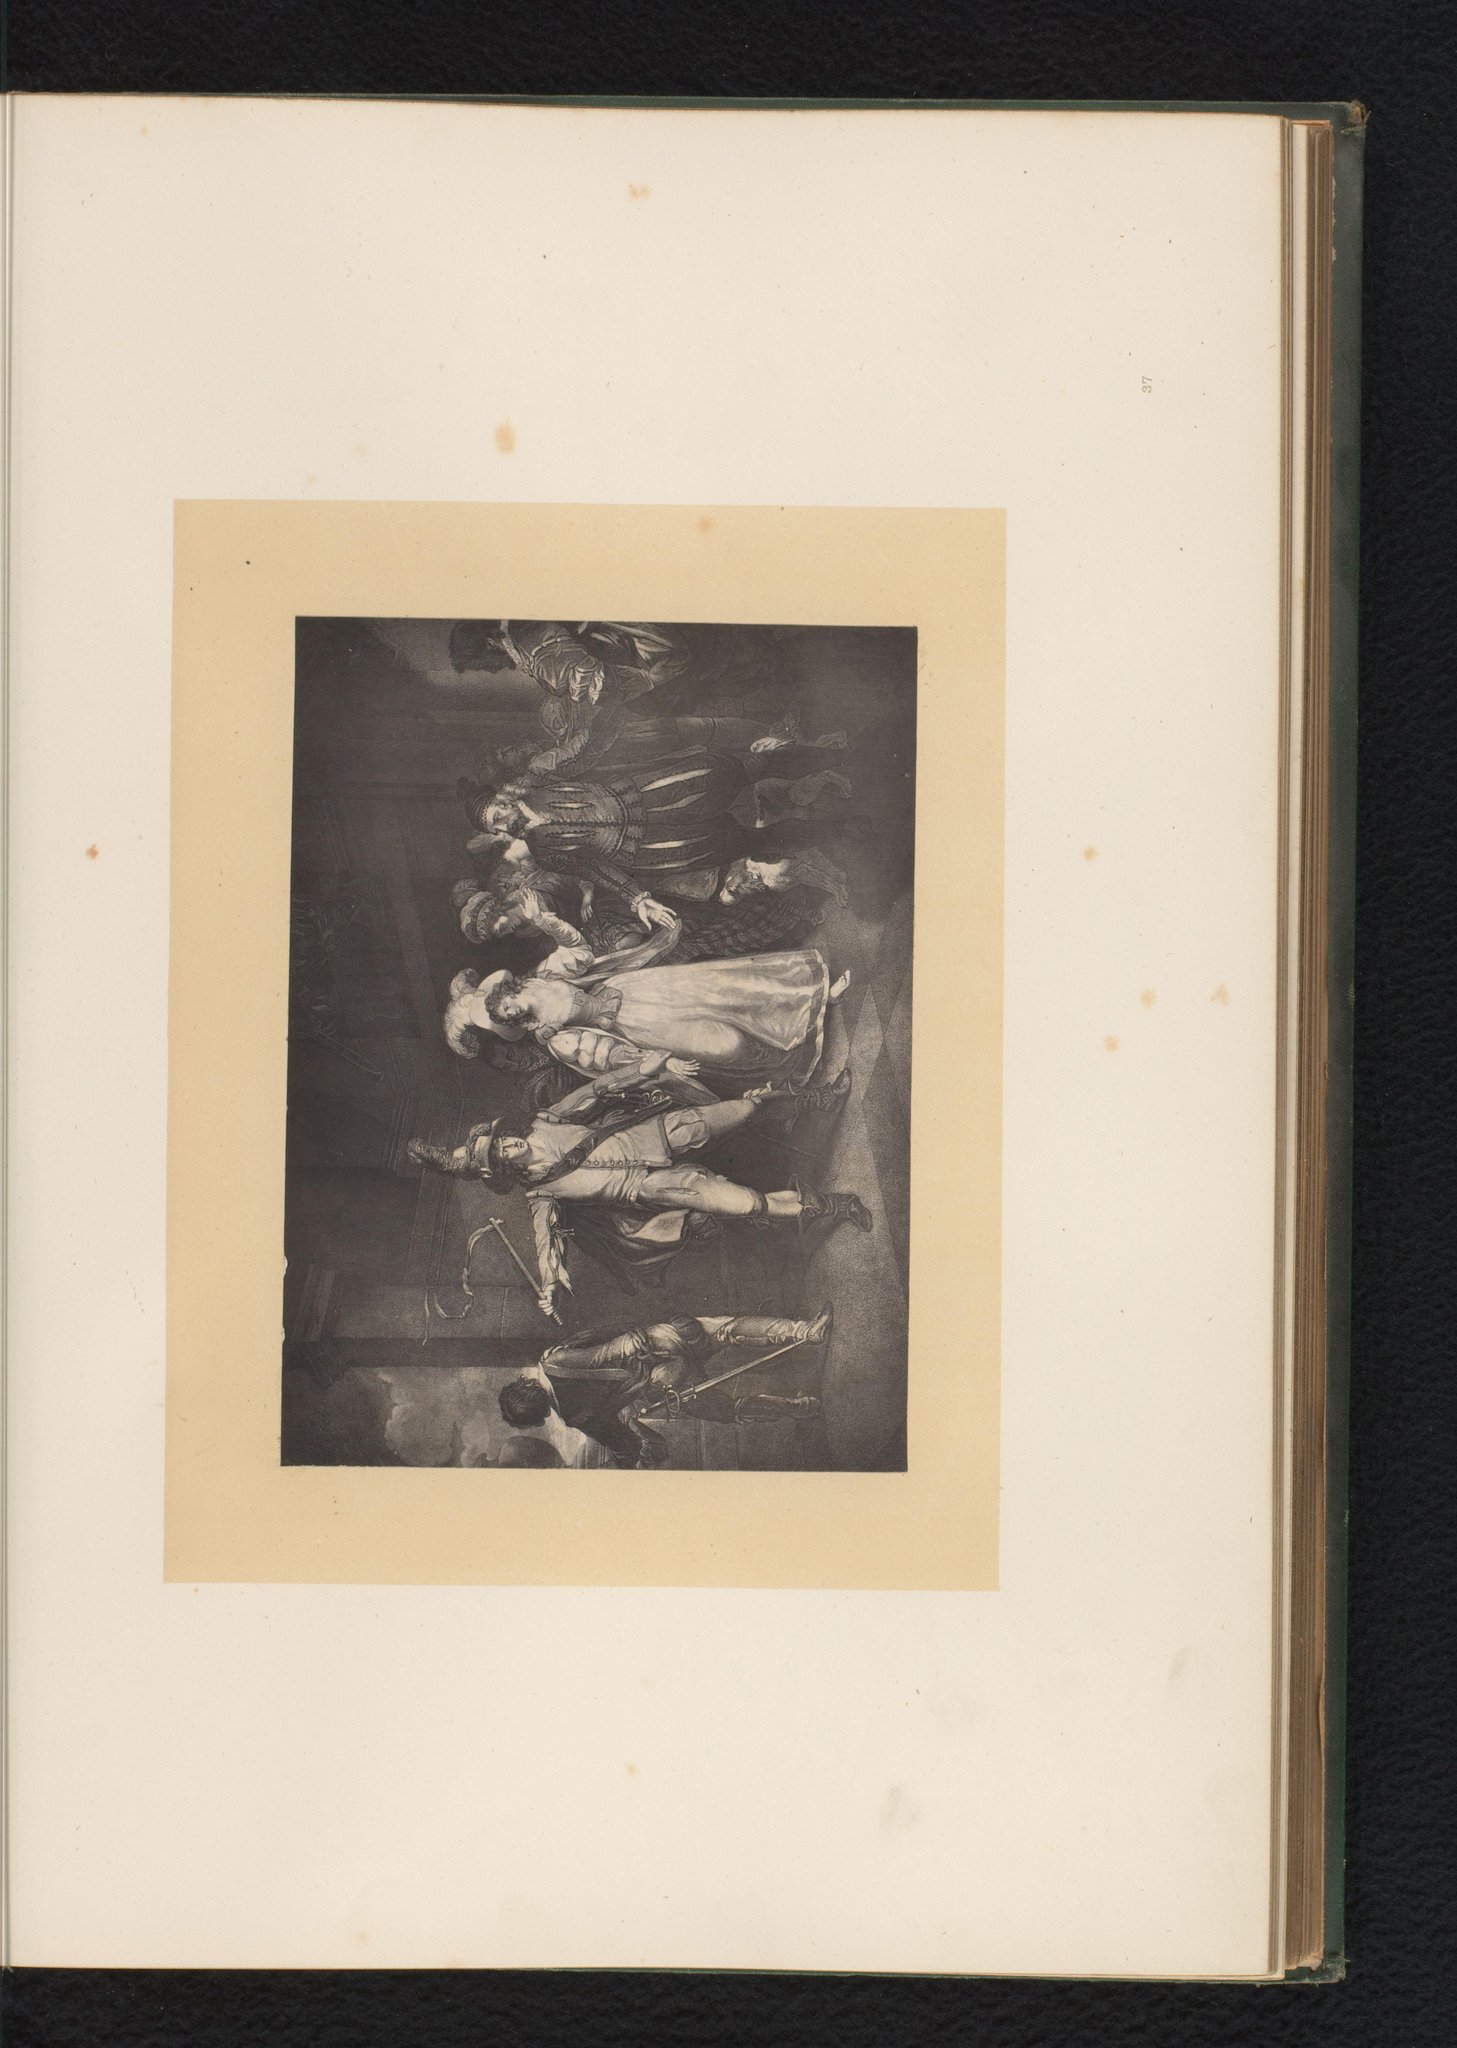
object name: page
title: Reproductie van een gravure naar een schilderij van een scène uit The Taming of the Shrew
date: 1874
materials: paper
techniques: woodburytype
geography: london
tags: 83(shakespeare, the taming of the shrew)